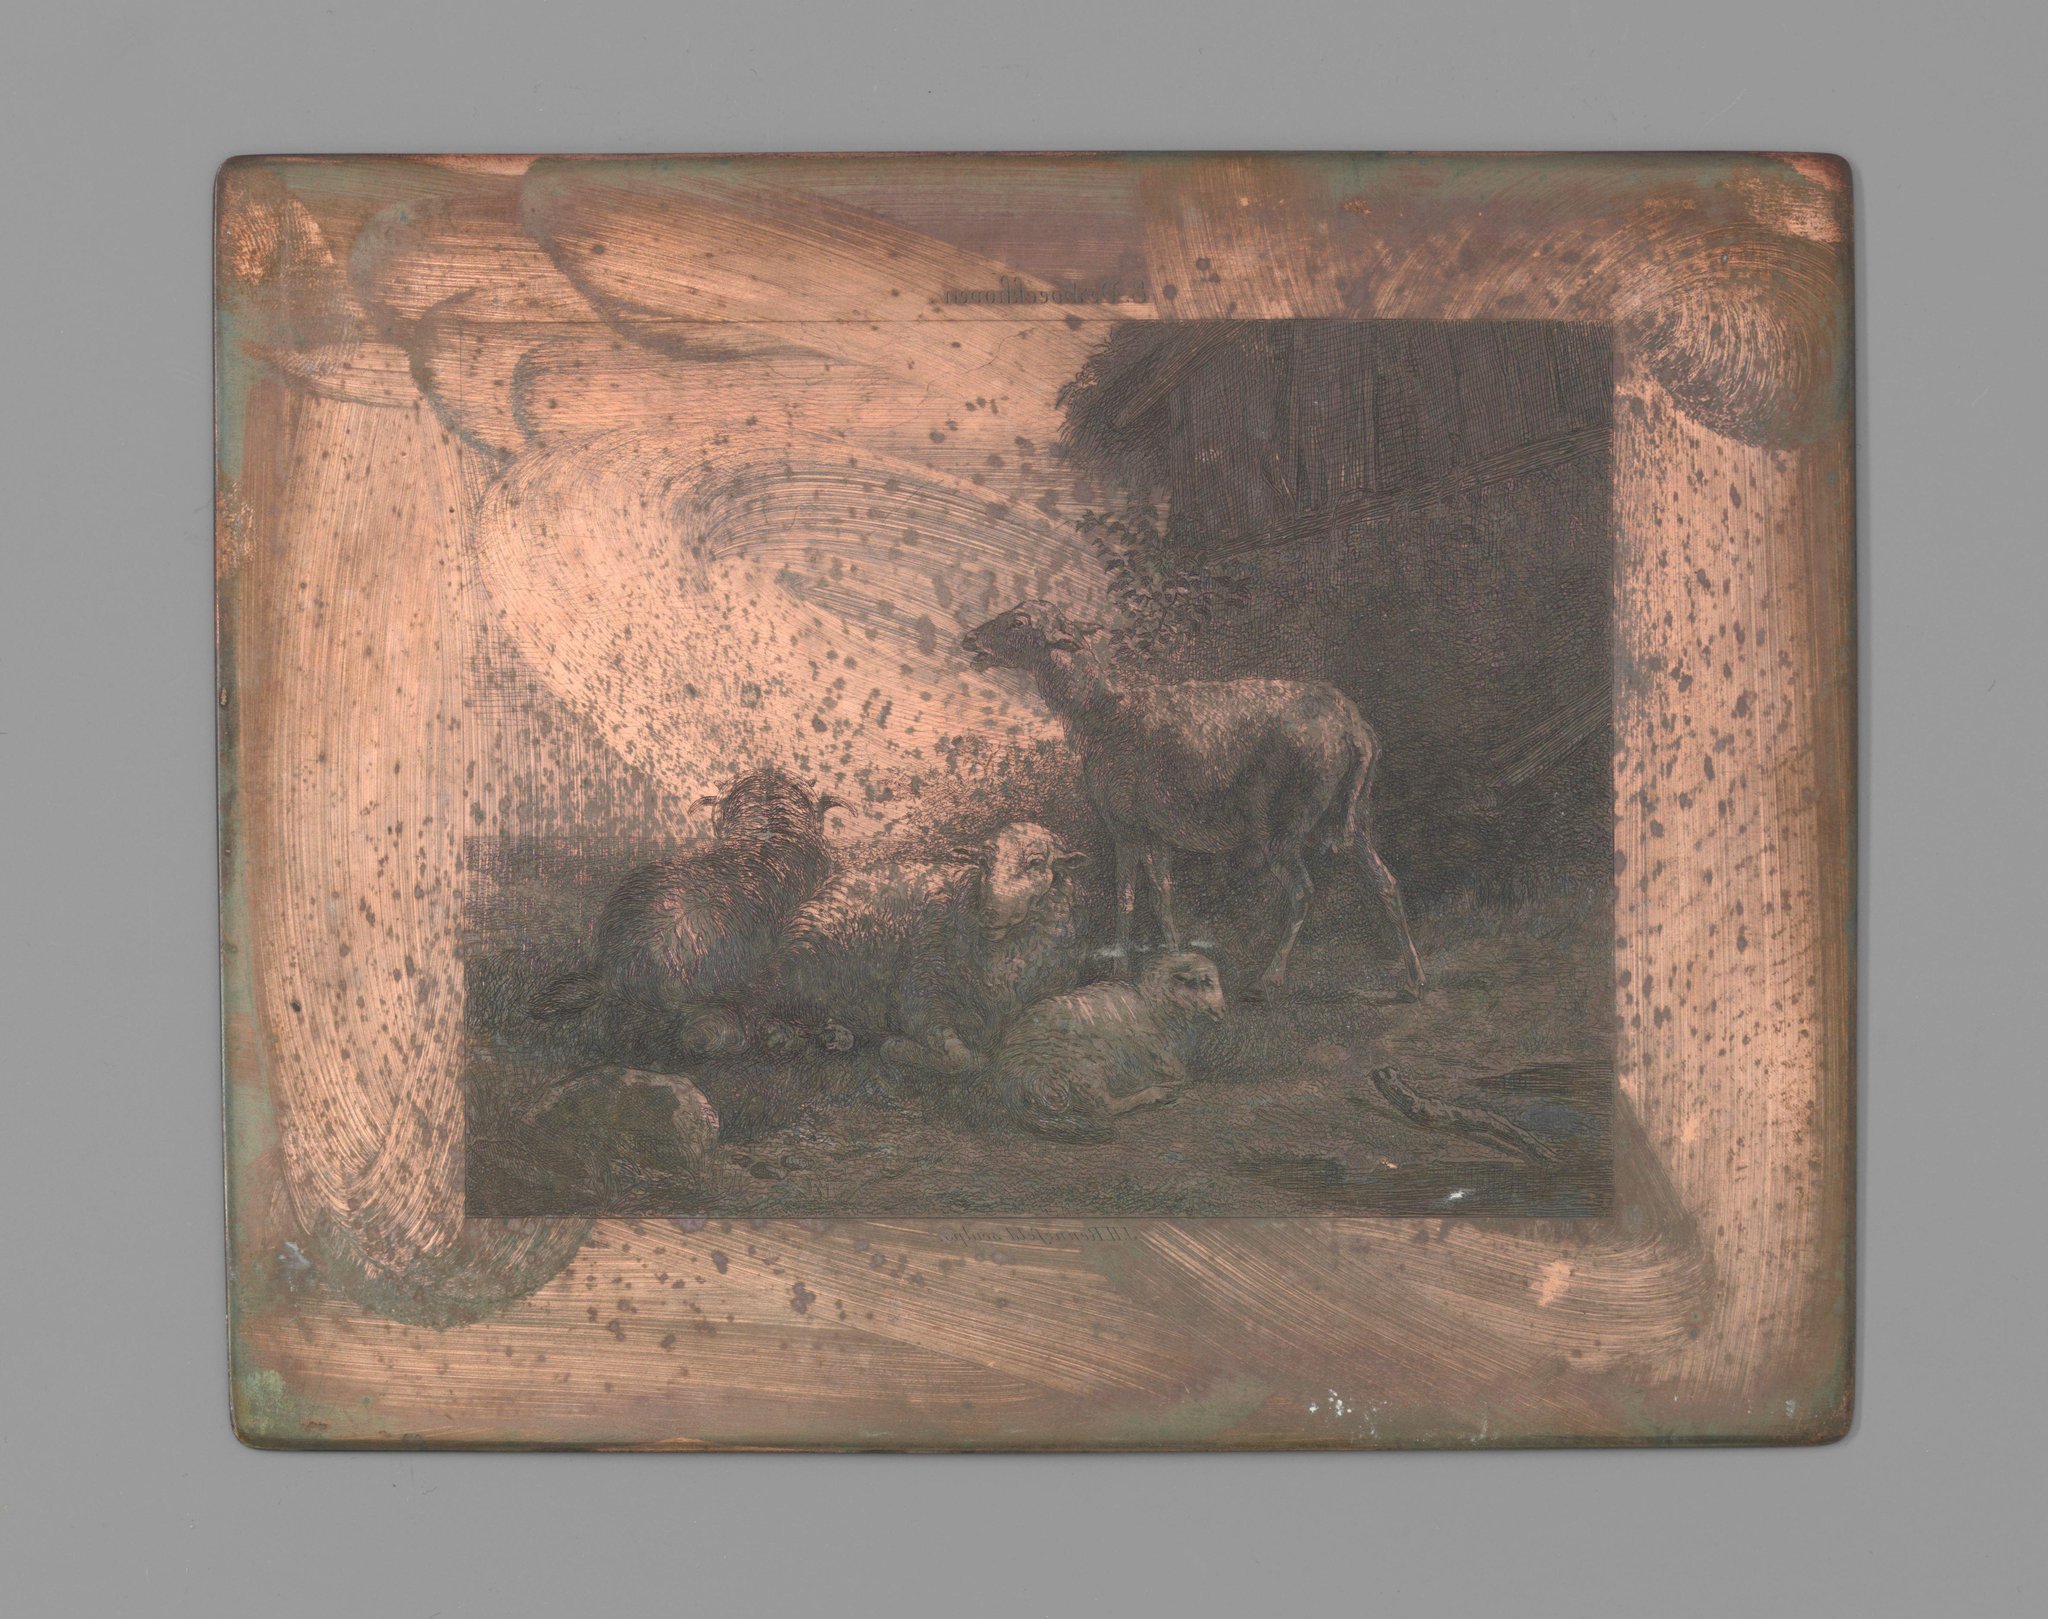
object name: copper plate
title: Vier schapen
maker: johann heinrich maria hubert rennefeld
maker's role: print maker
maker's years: 1832-1877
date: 1842-1870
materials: copper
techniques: etching